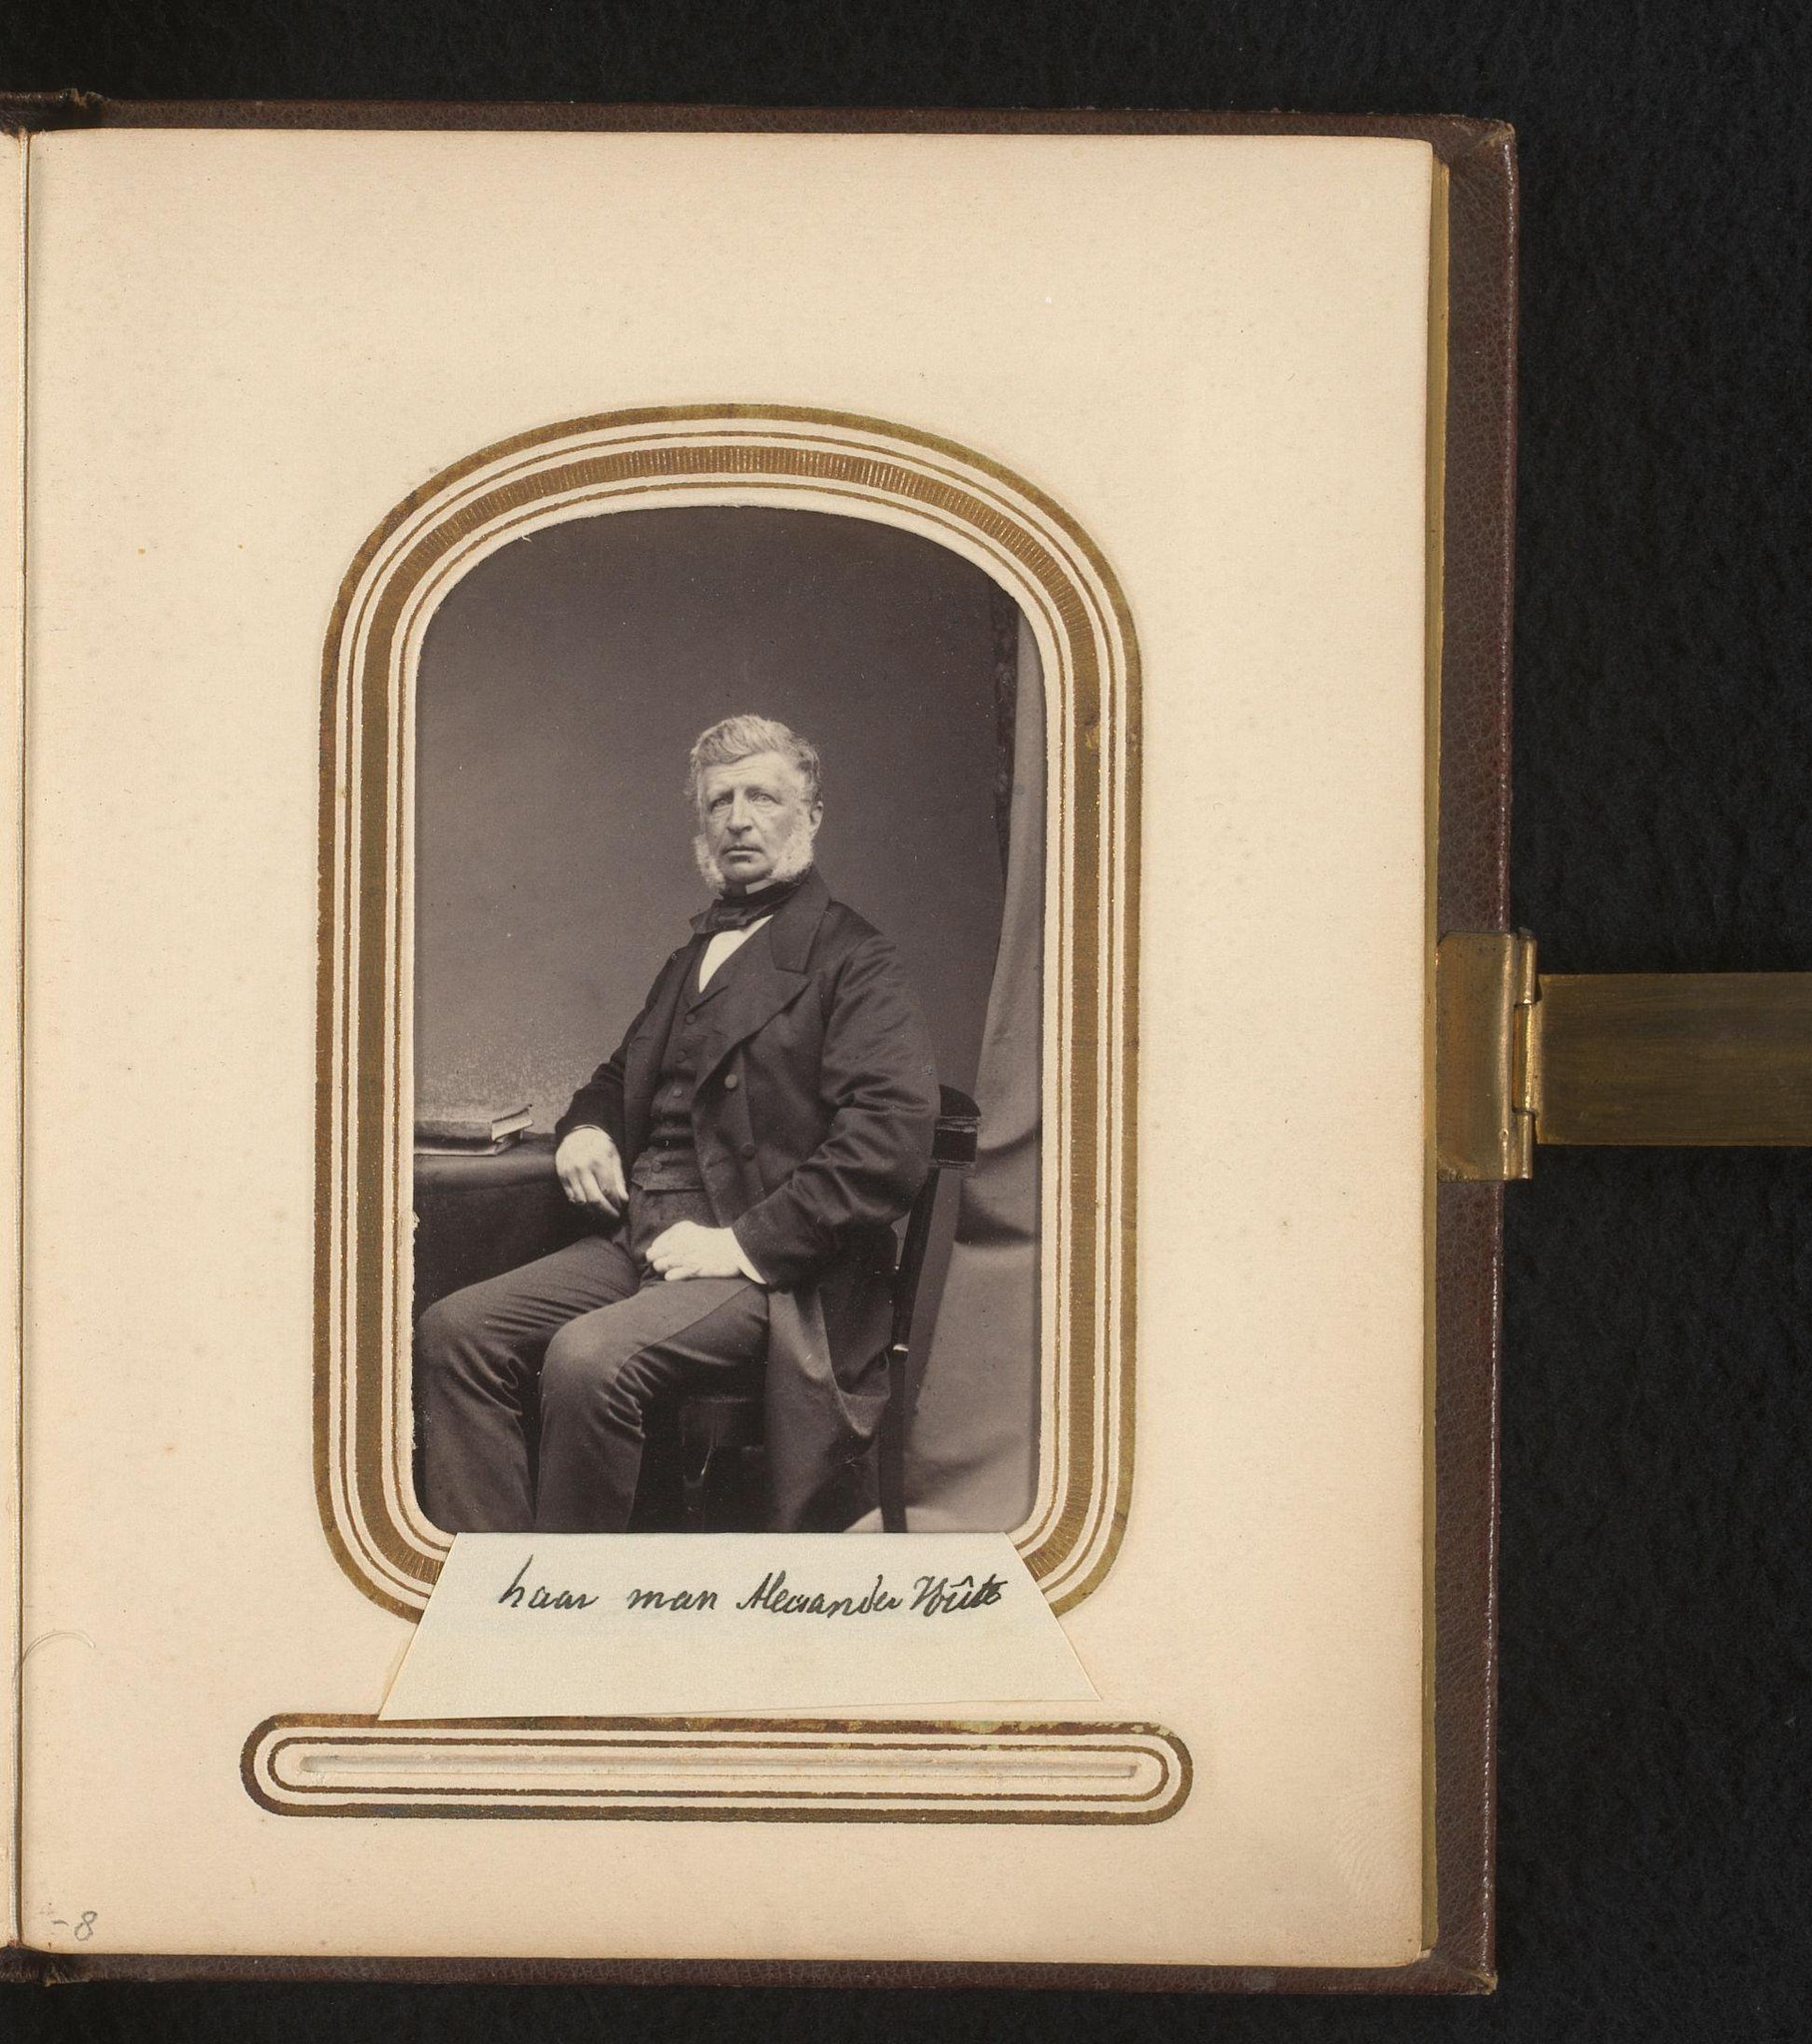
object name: photograph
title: Haat man Alexander Voûte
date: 1857-1864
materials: cardboard, paper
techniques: albumen print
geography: amsterdam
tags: amsterdam, historical persons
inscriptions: address: ‘Prinsengracht BB.439/ AMSTERDAM’